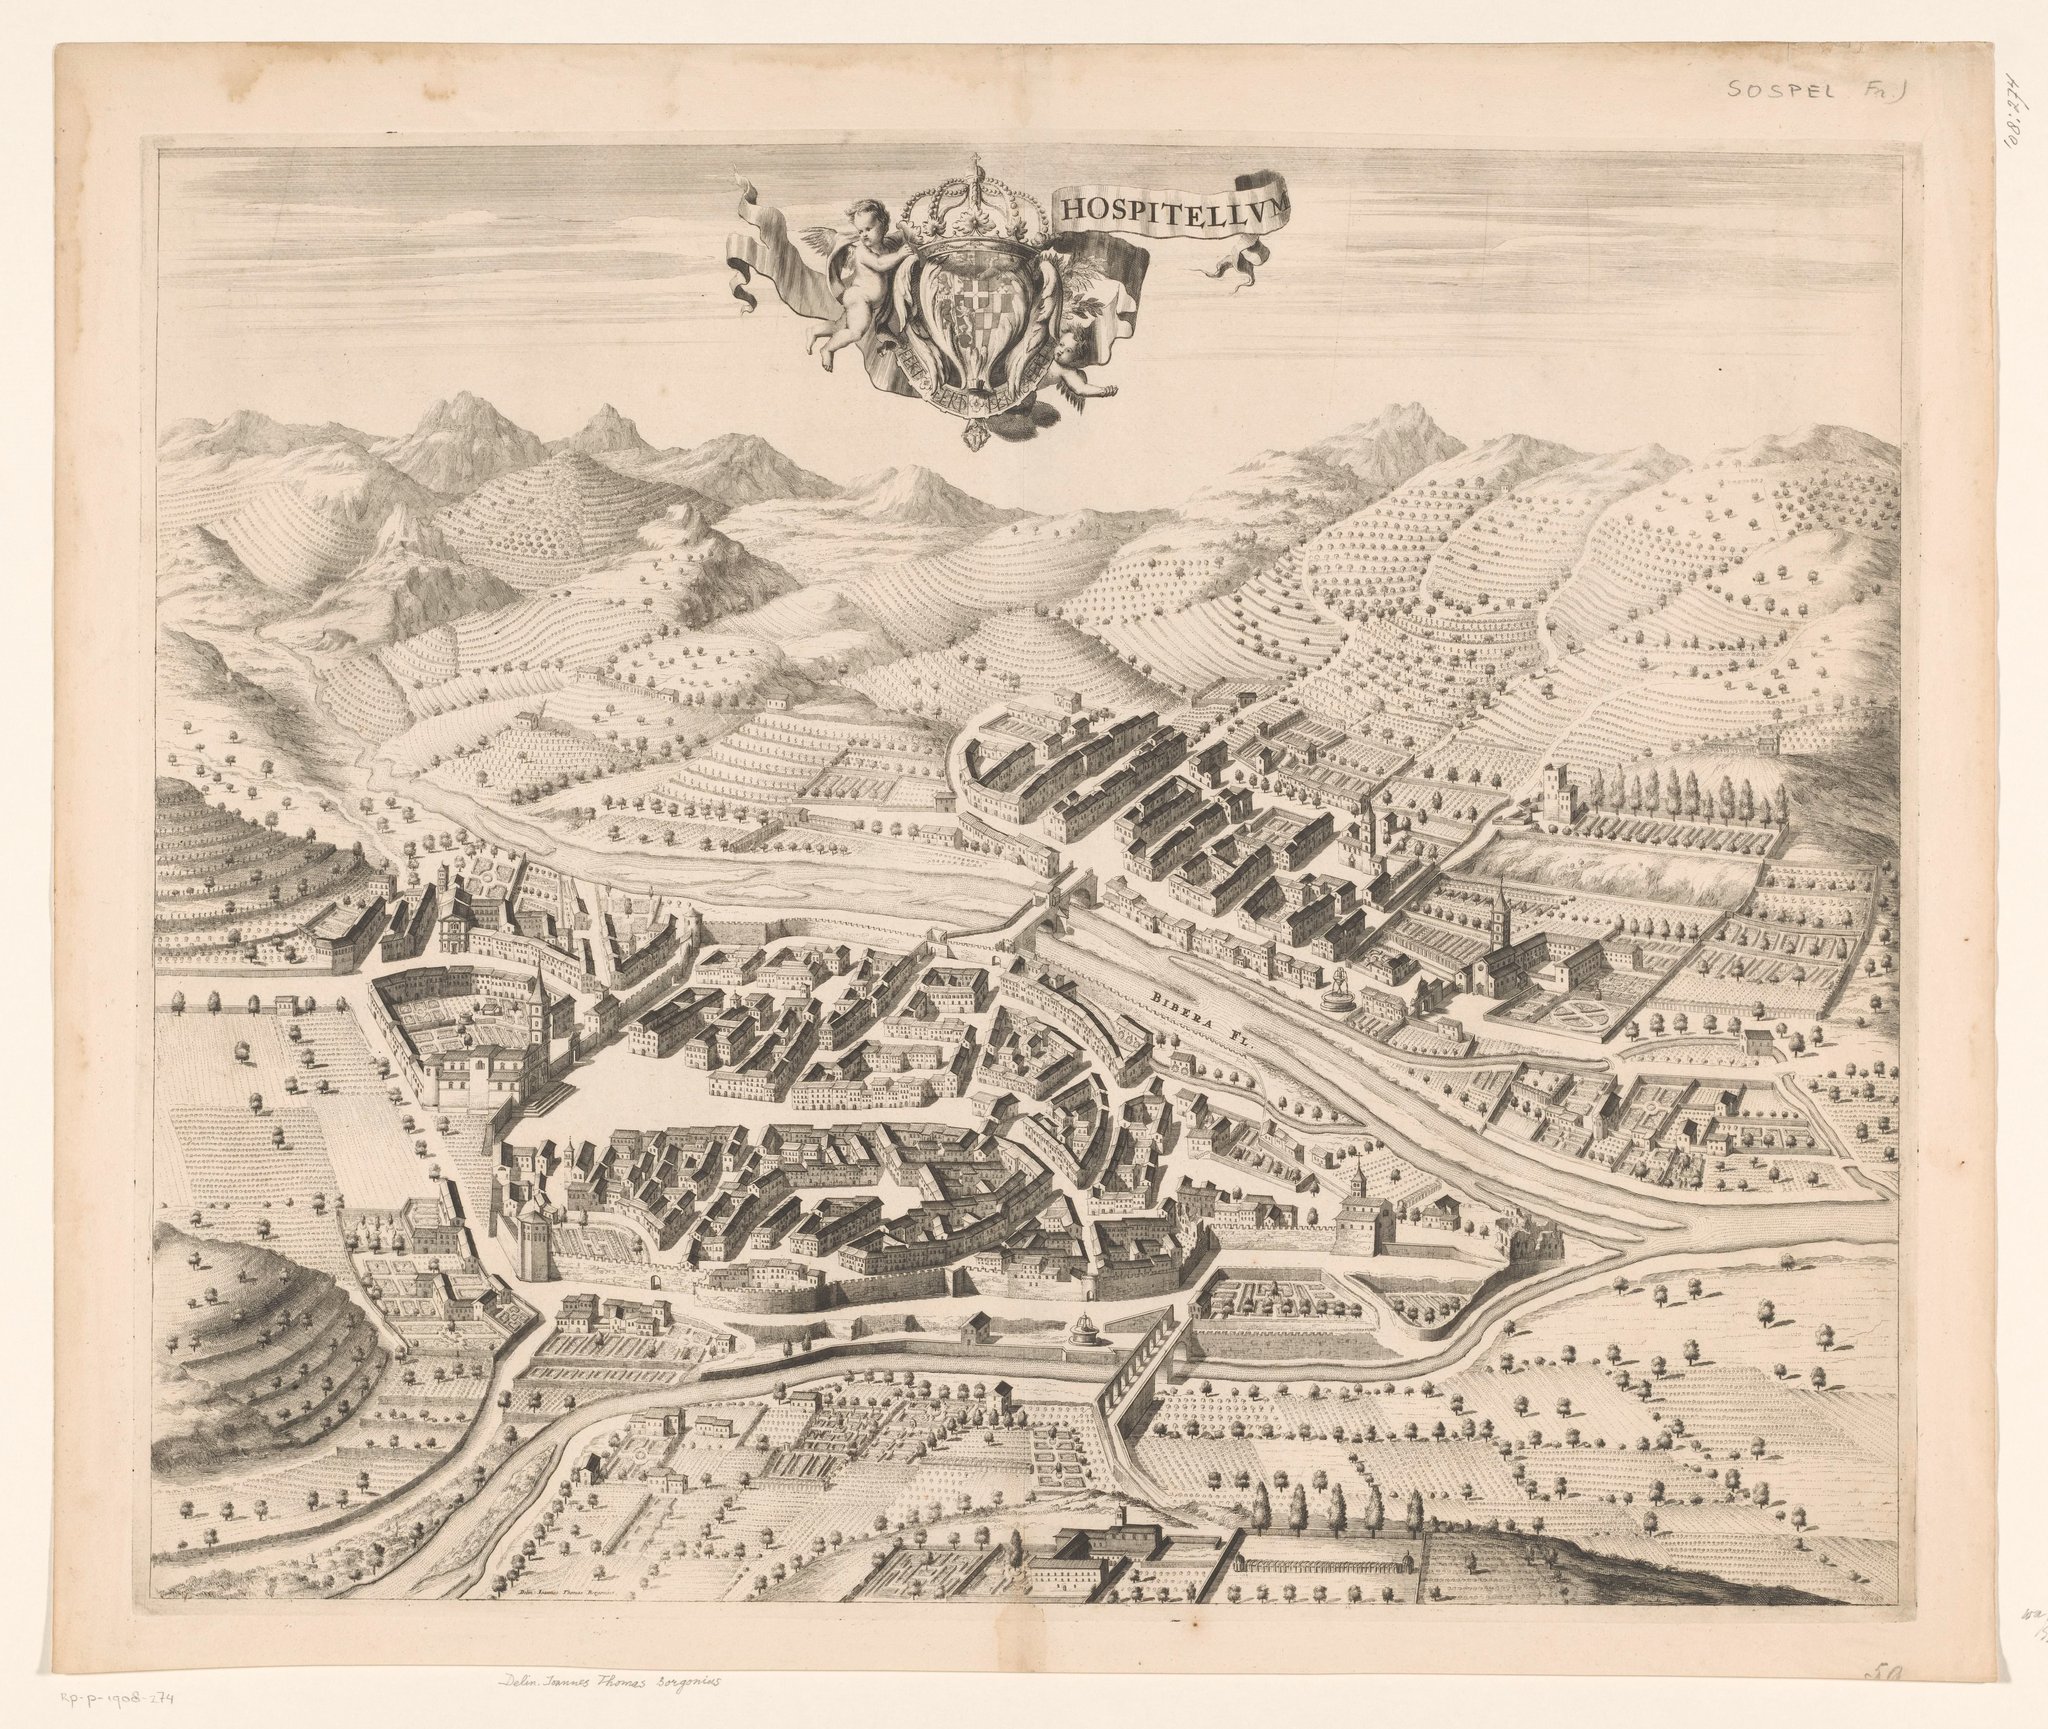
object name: print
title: Hospitellum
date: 1682-1697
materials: paper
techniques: engraving, etching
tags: maps of cities, armorial bearing, heraldry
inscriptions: collector's mark: Lugt 2228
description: Plattegrond van Sospel in vogelvluchtperspectief.